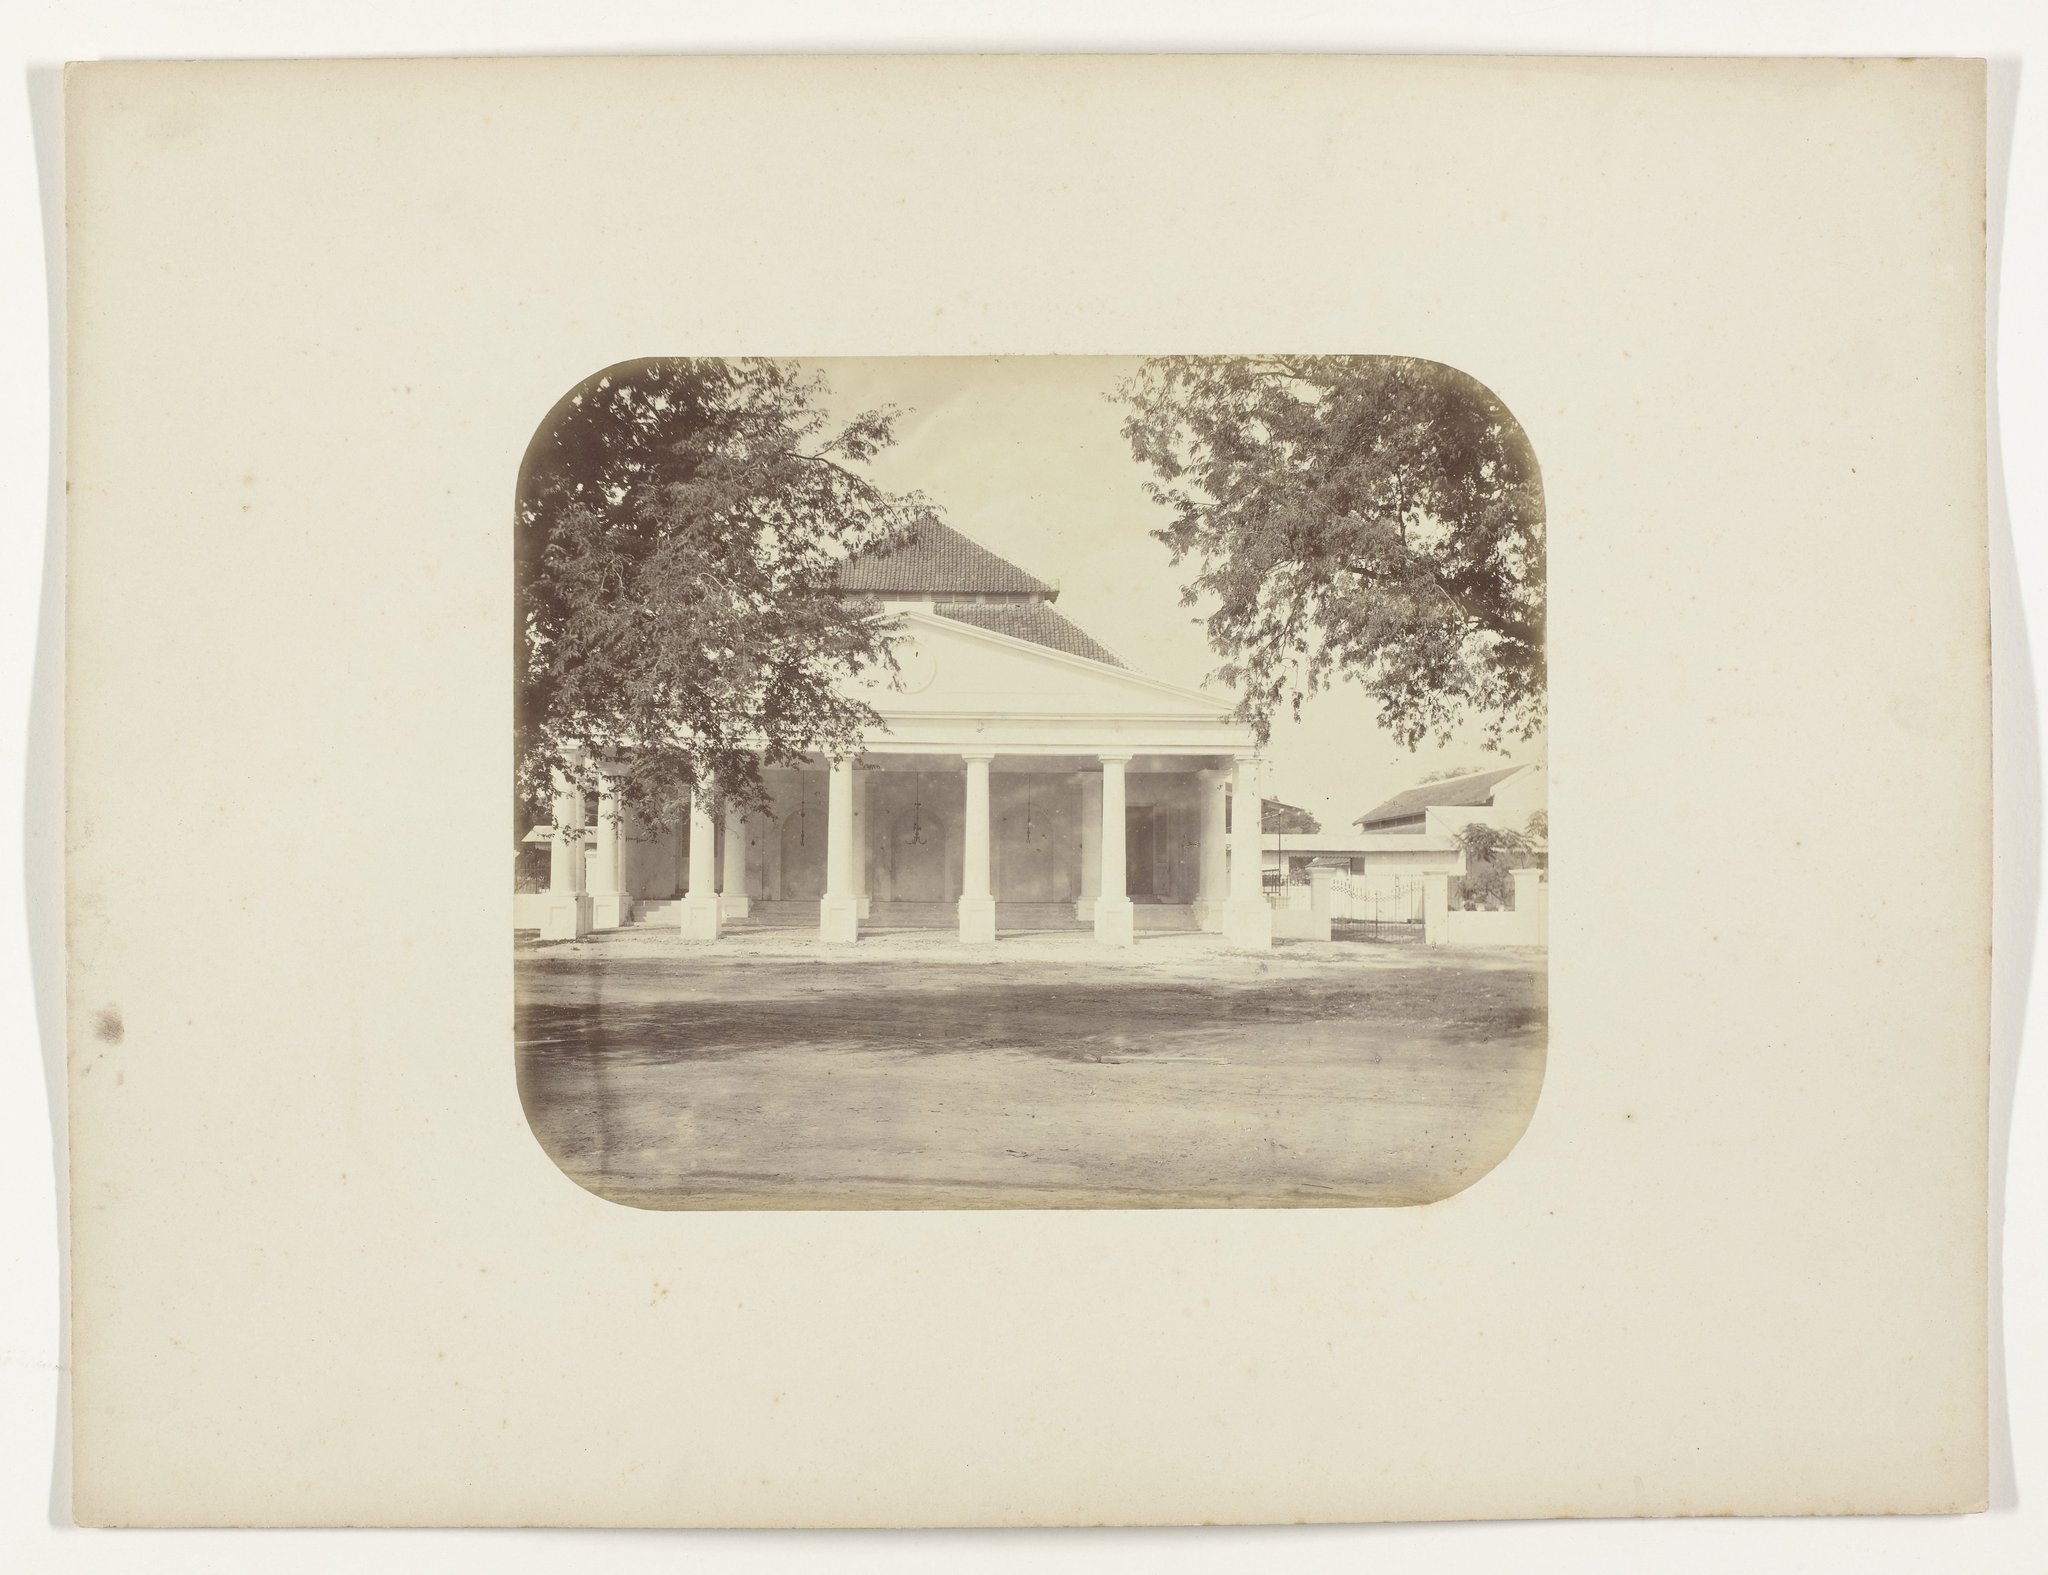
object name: photograph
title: Een verenigingsgebouw in Surabaya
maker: herman salzwedel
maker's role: fotograaf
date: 1876-1884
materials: photographic support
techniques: albumen print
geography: surabaya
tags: utrecht, the hague, colonial system, club, meeting place, detached house in city, surabaya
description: Een verenigingsgebouw in Surabaya (misschien de 'loge') met rechts van het huis een hek. De toegang tot het gebouw via een brede trap met vijf treden, onderbroken door zuilen. Onderdeel van het fotoalbum door de Soerabayasche Vereeniging van Suikerfabrikanten aangeboden aan Frederik Beyerinck, resident van Soerabaja.